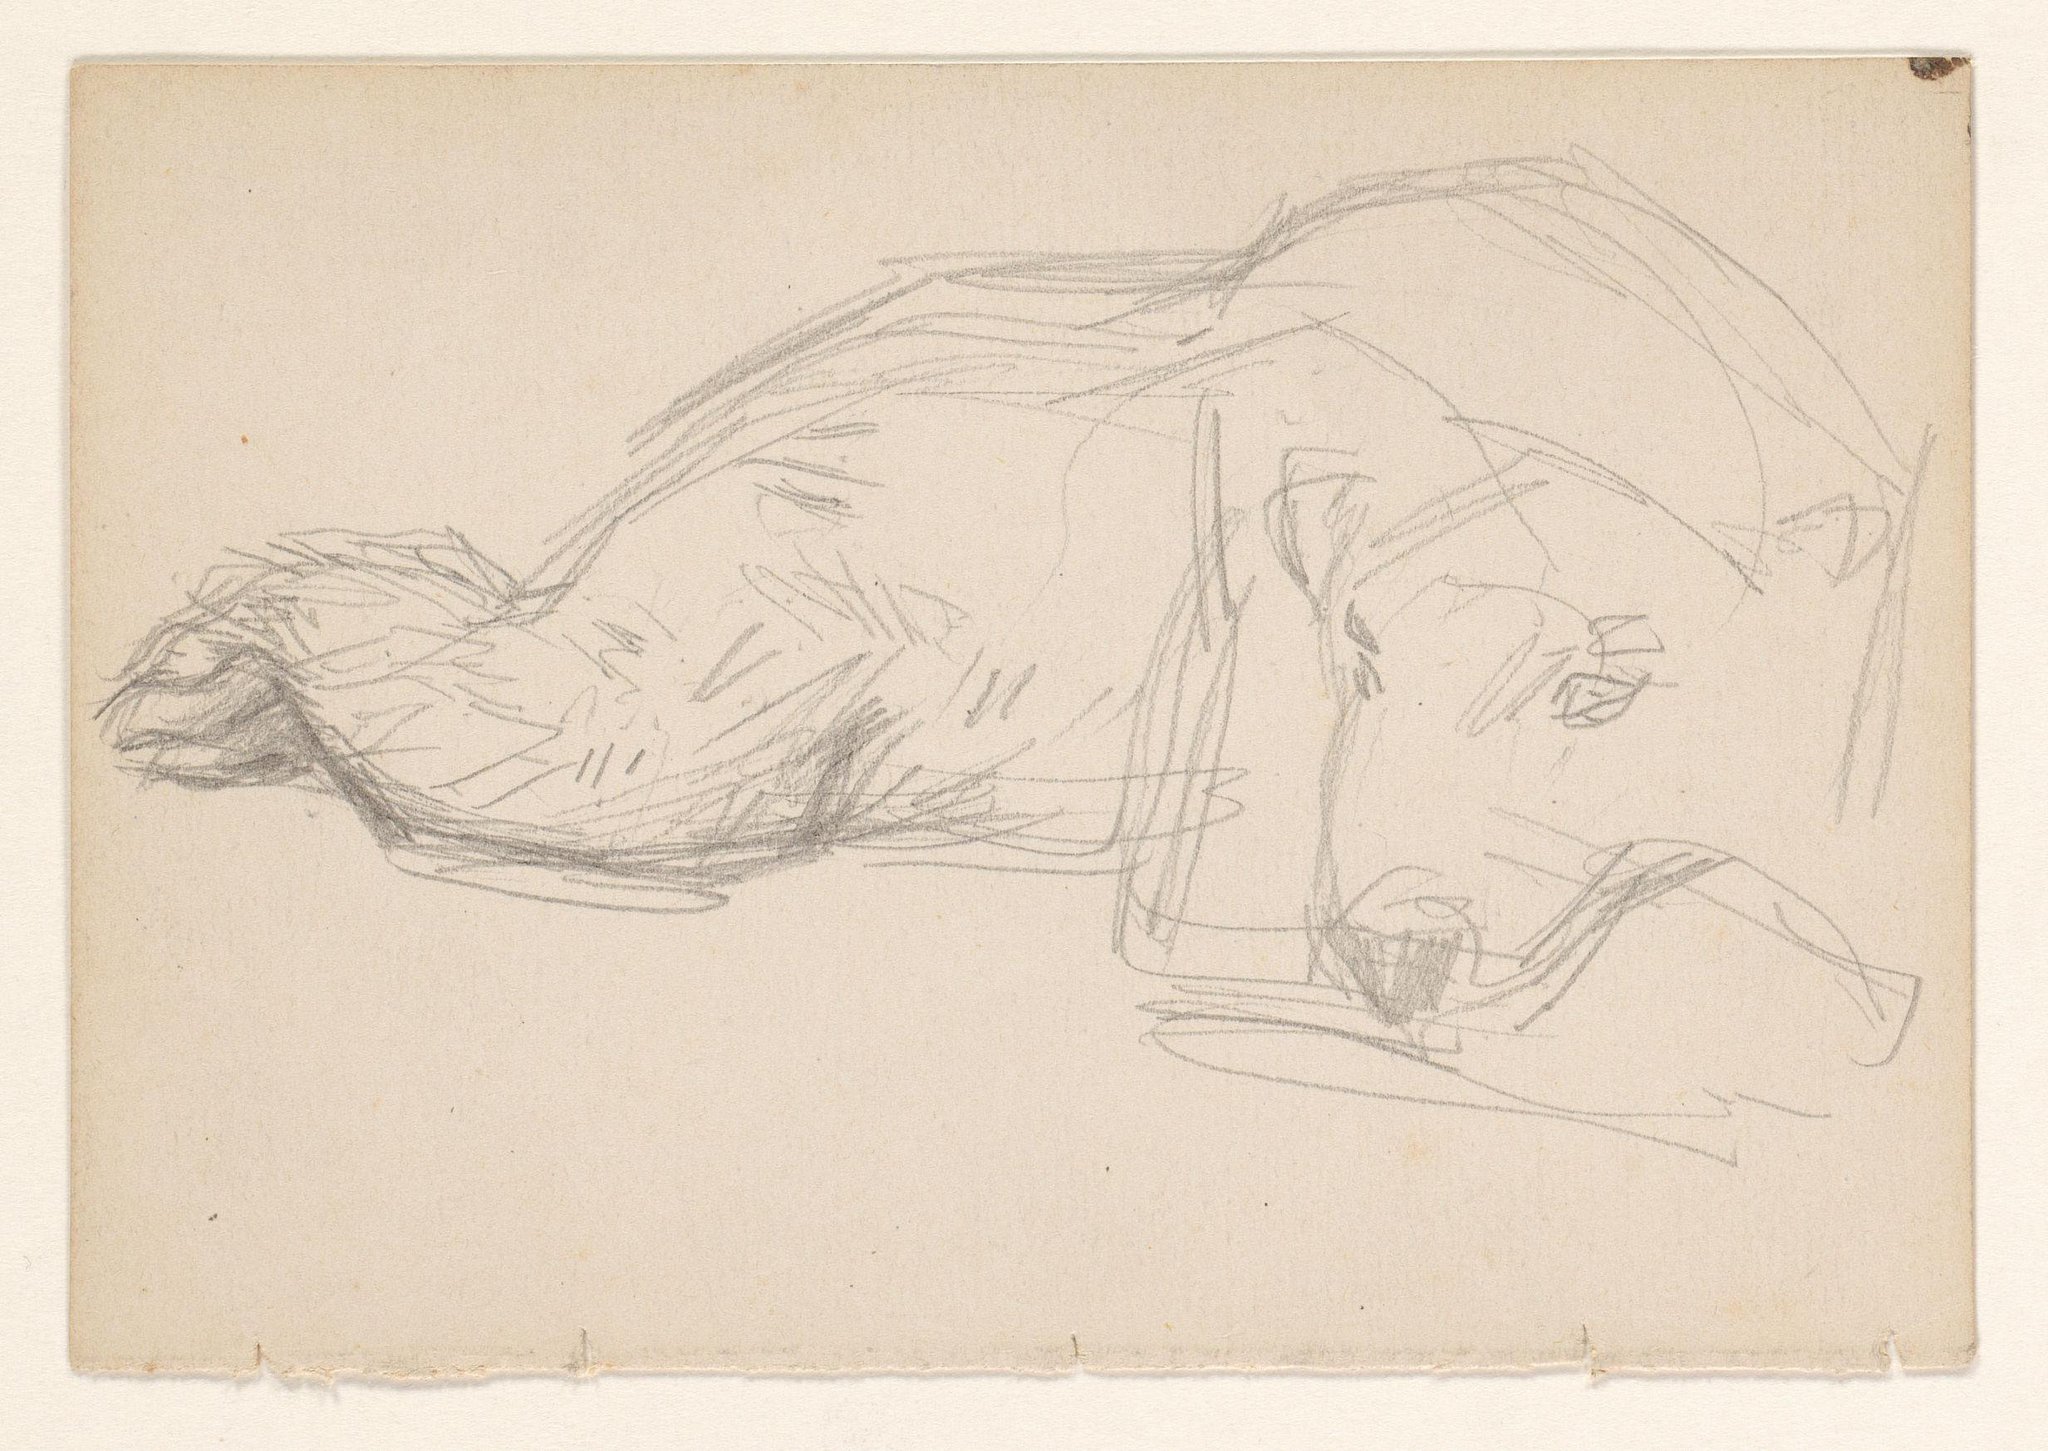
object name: drawing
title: Schets van een liggende ijsbeer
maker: august allebé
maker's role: draughtsman, print maker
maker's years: 1838-1927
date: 1848-1927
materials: paper, pencil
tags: beasts of prey, predatory animals: polar bear